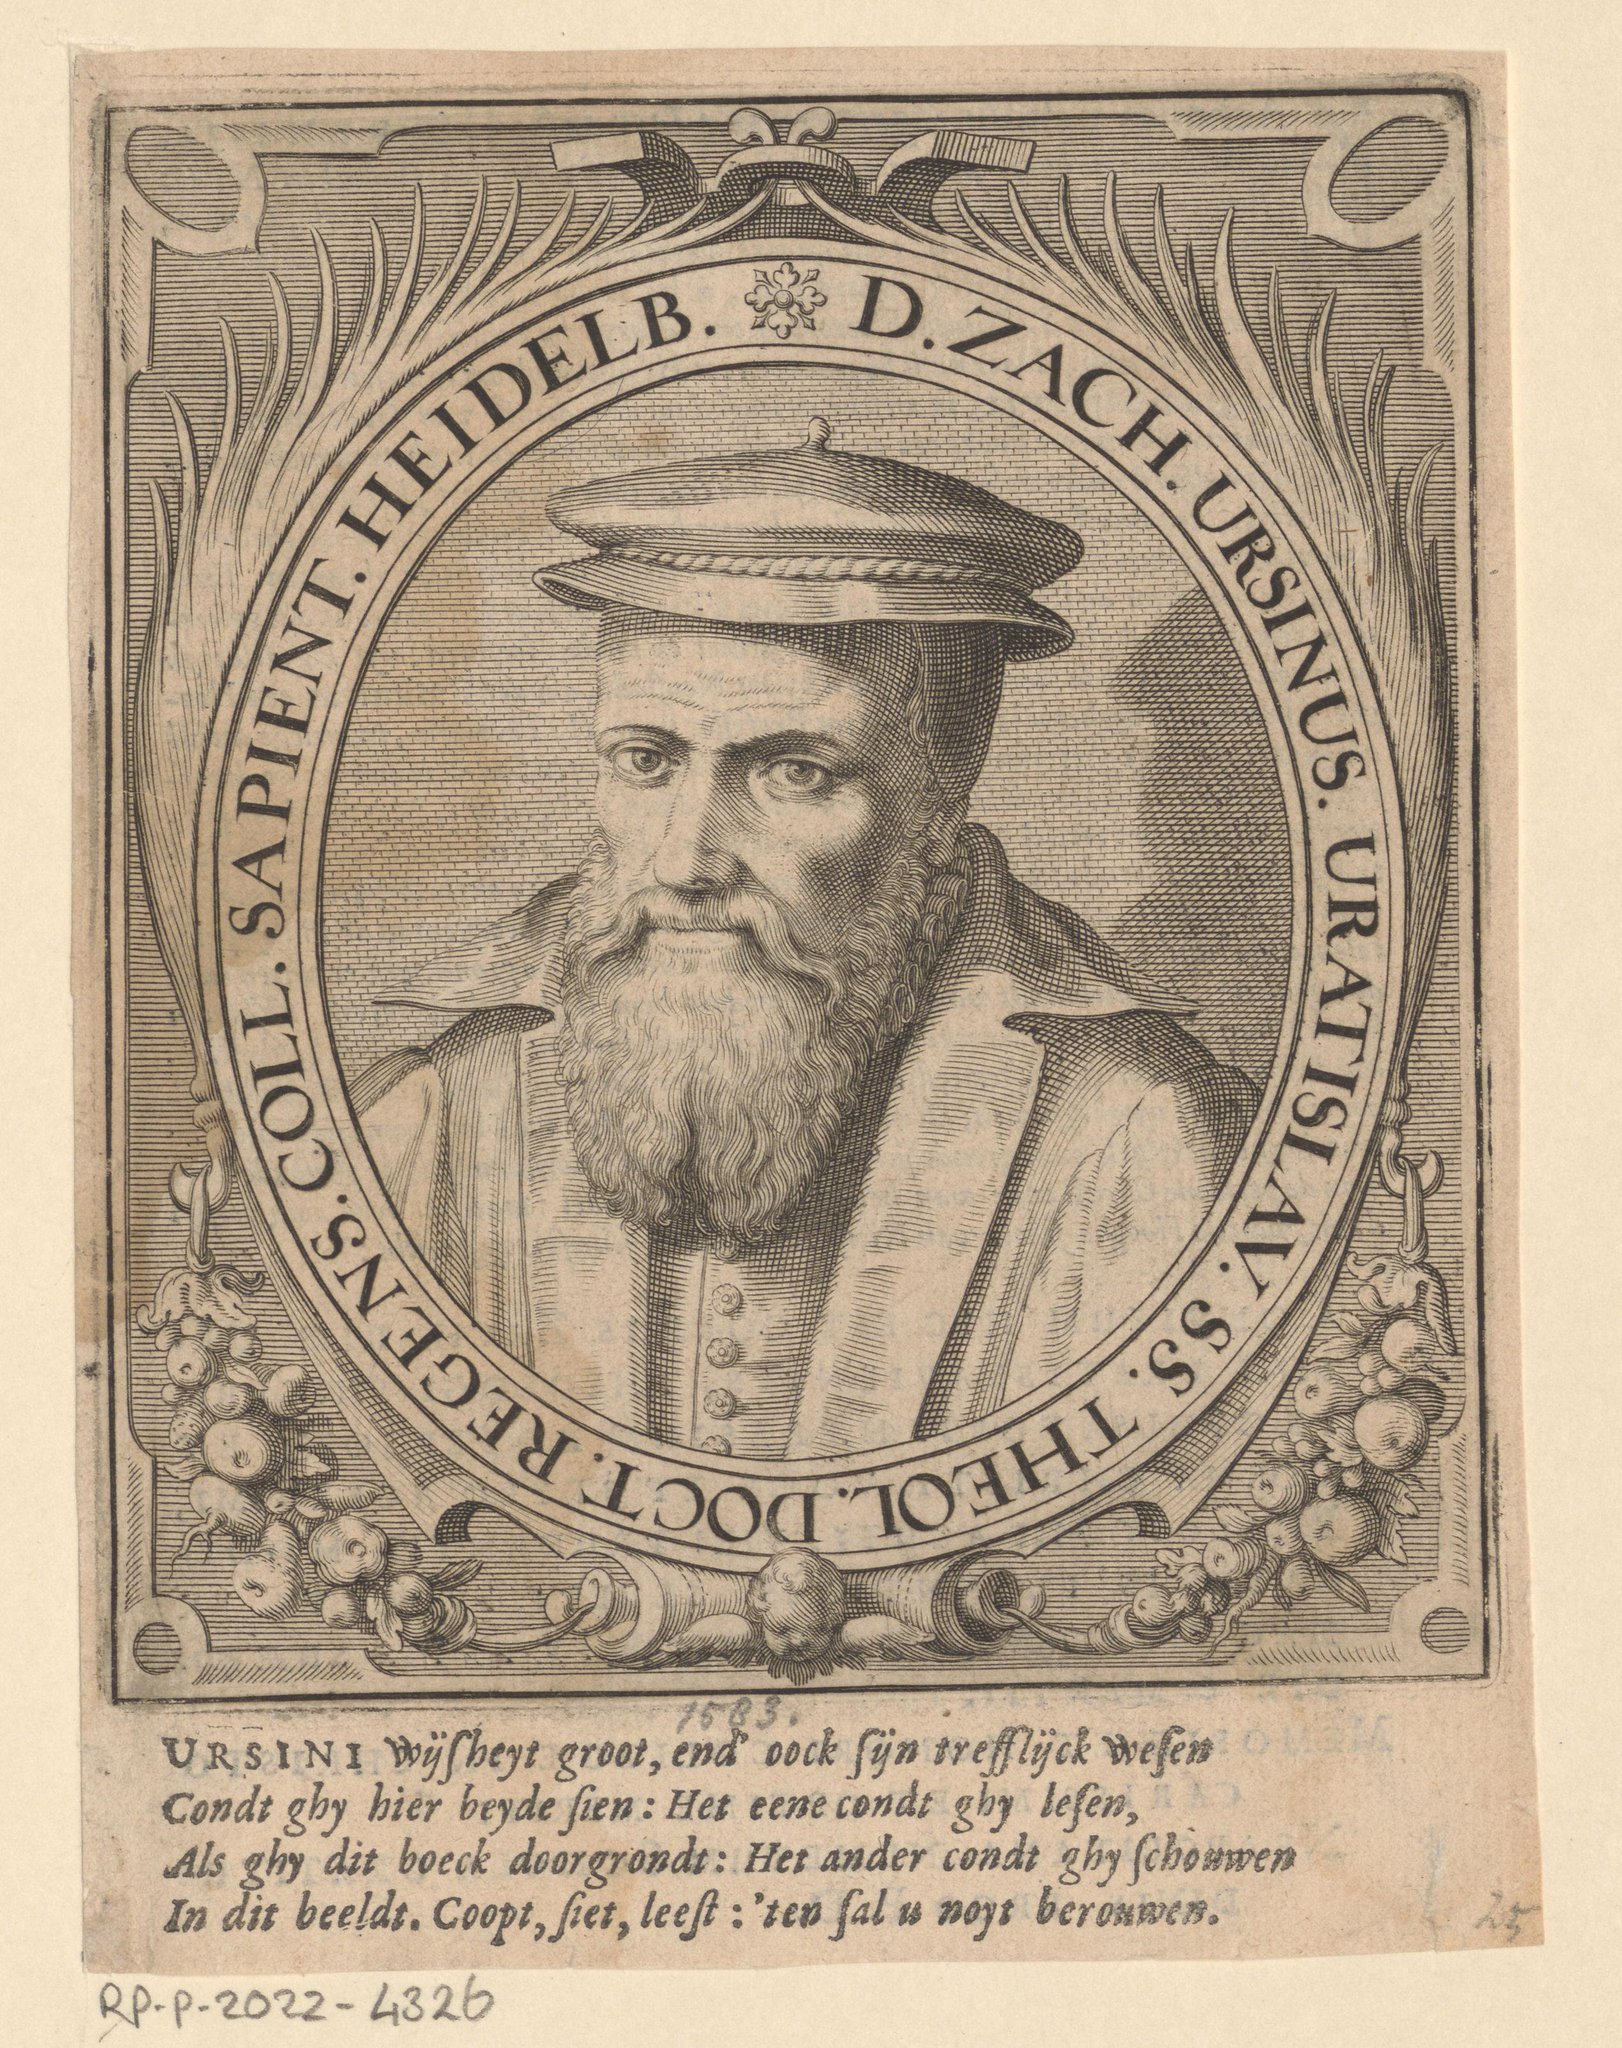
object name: book illustration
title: Portret van Zacharias Ursinus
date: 1606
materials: paper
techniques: engraving, letterpress printing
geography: leiden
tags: theologian, historical persons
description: Prent uit: Ursinus, Zacharias, David Pareus, Festus Hommius, Jermias Bastingius. Het schat-boeck der christelycke leere (...) Leiden: Andries Clouck, 1606.